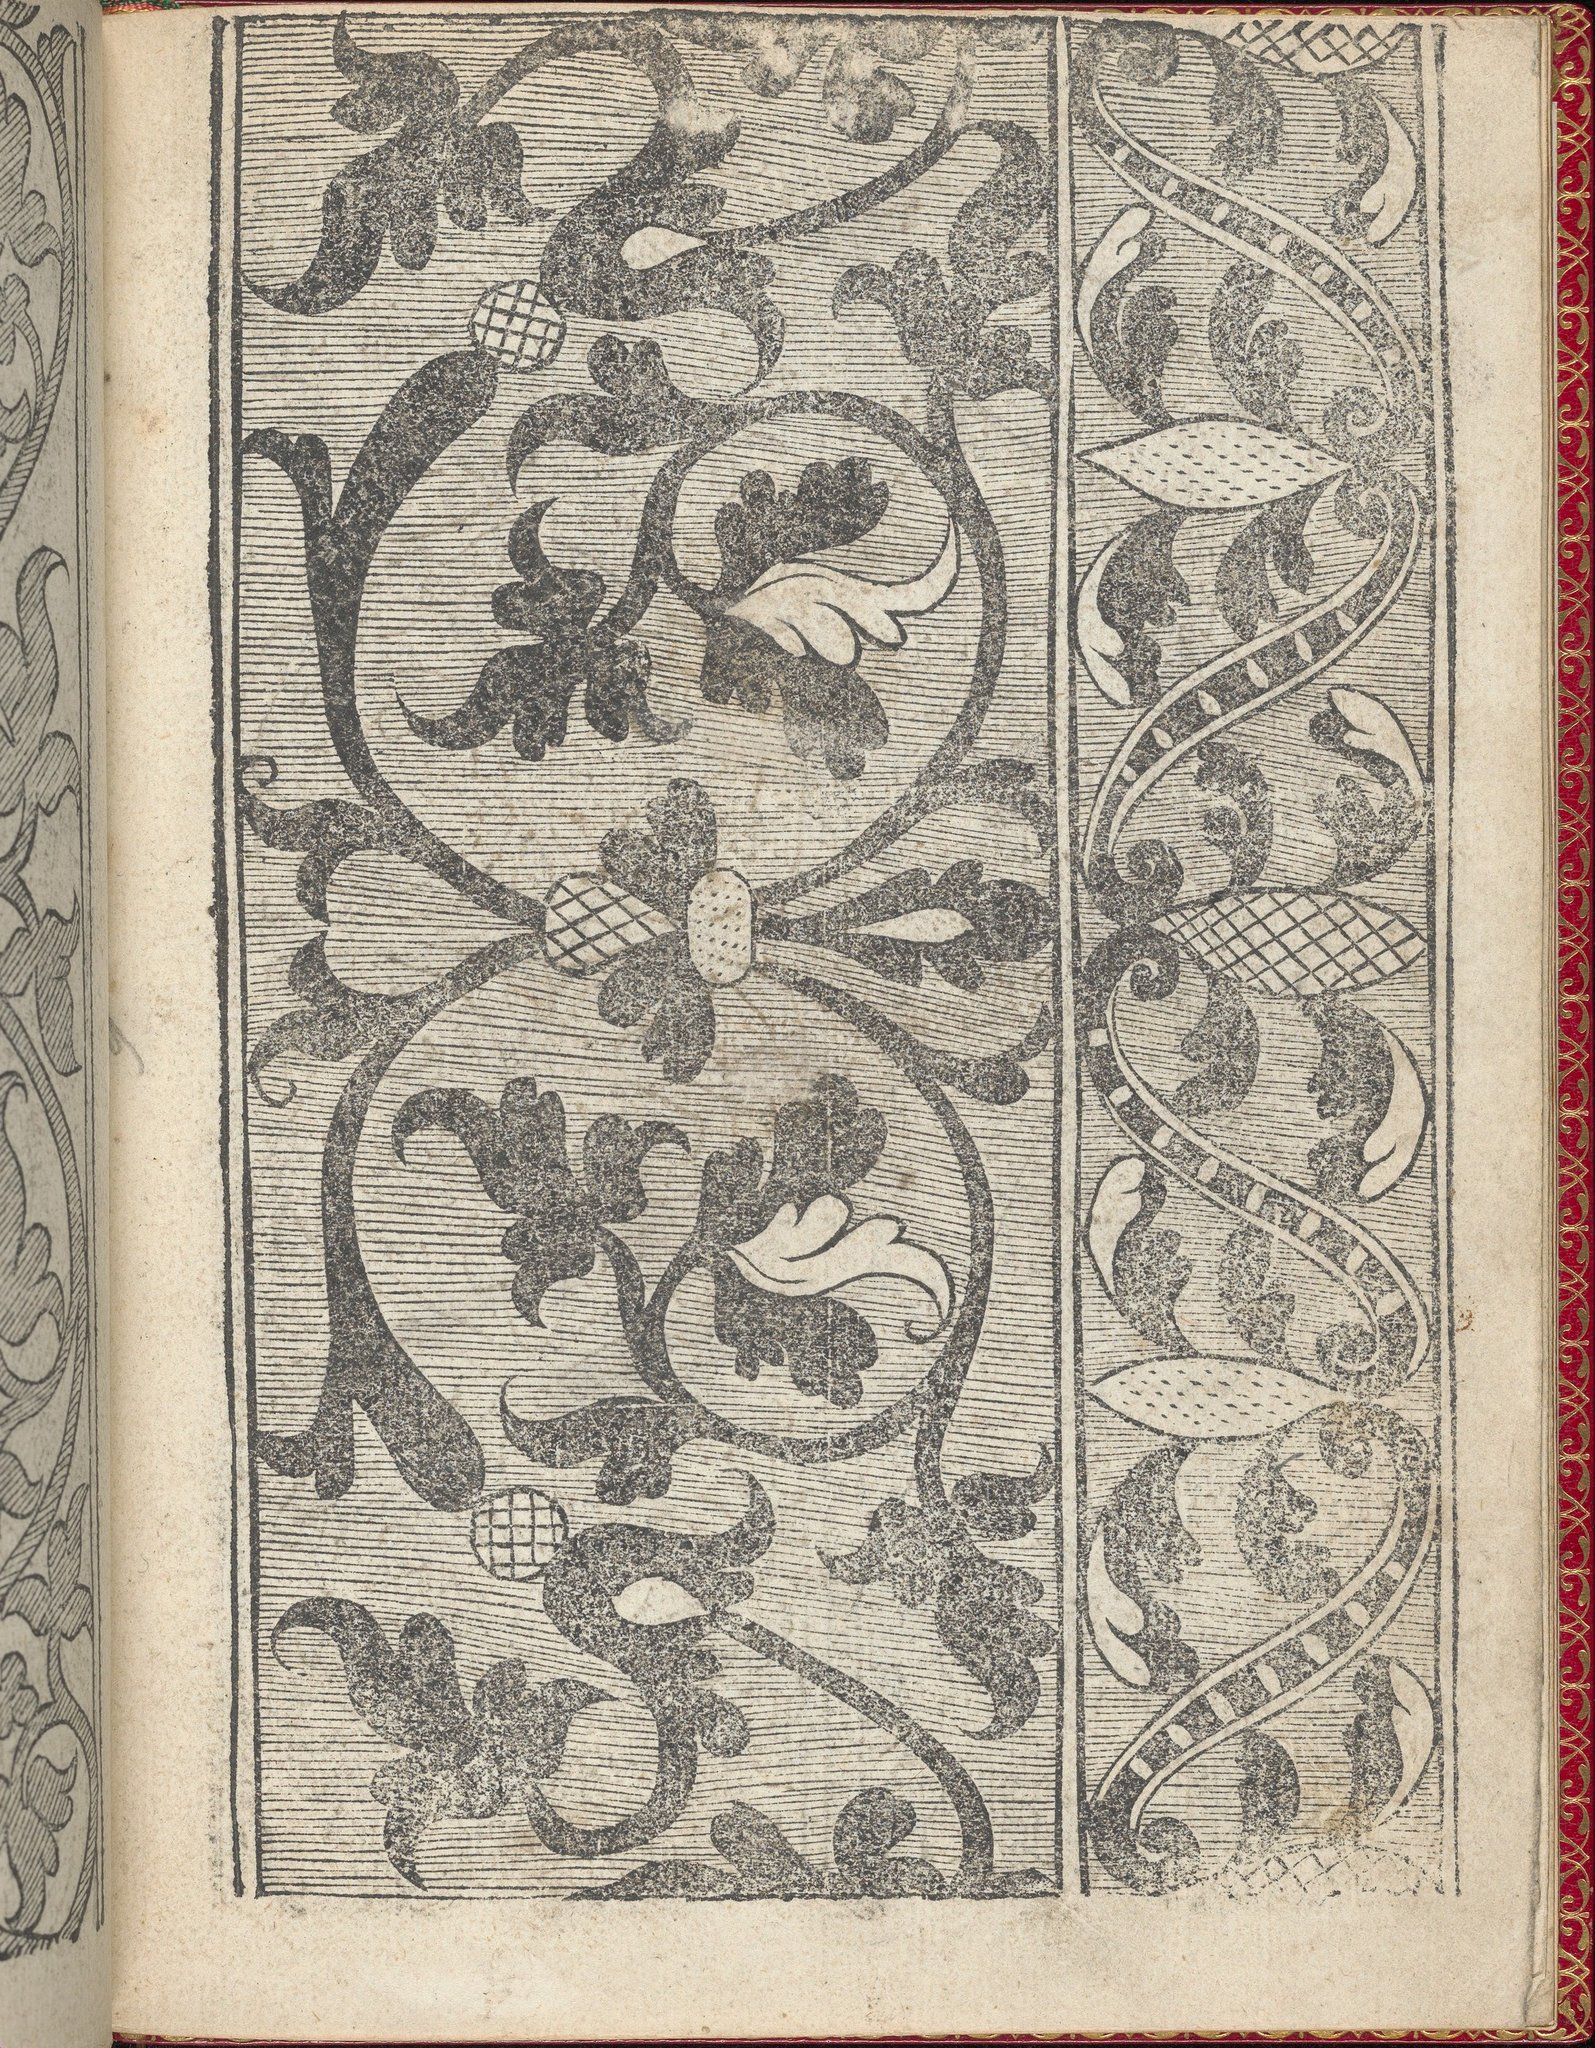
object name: book print ornament architecture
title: Il Monte. Opera Nova di Recami, page 5 (verso)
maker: giovanni antonio bindoni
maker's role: designer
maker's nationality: italian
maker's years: 1500-1650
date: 1557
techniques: woodcut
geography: italy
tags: flowers,acanthus